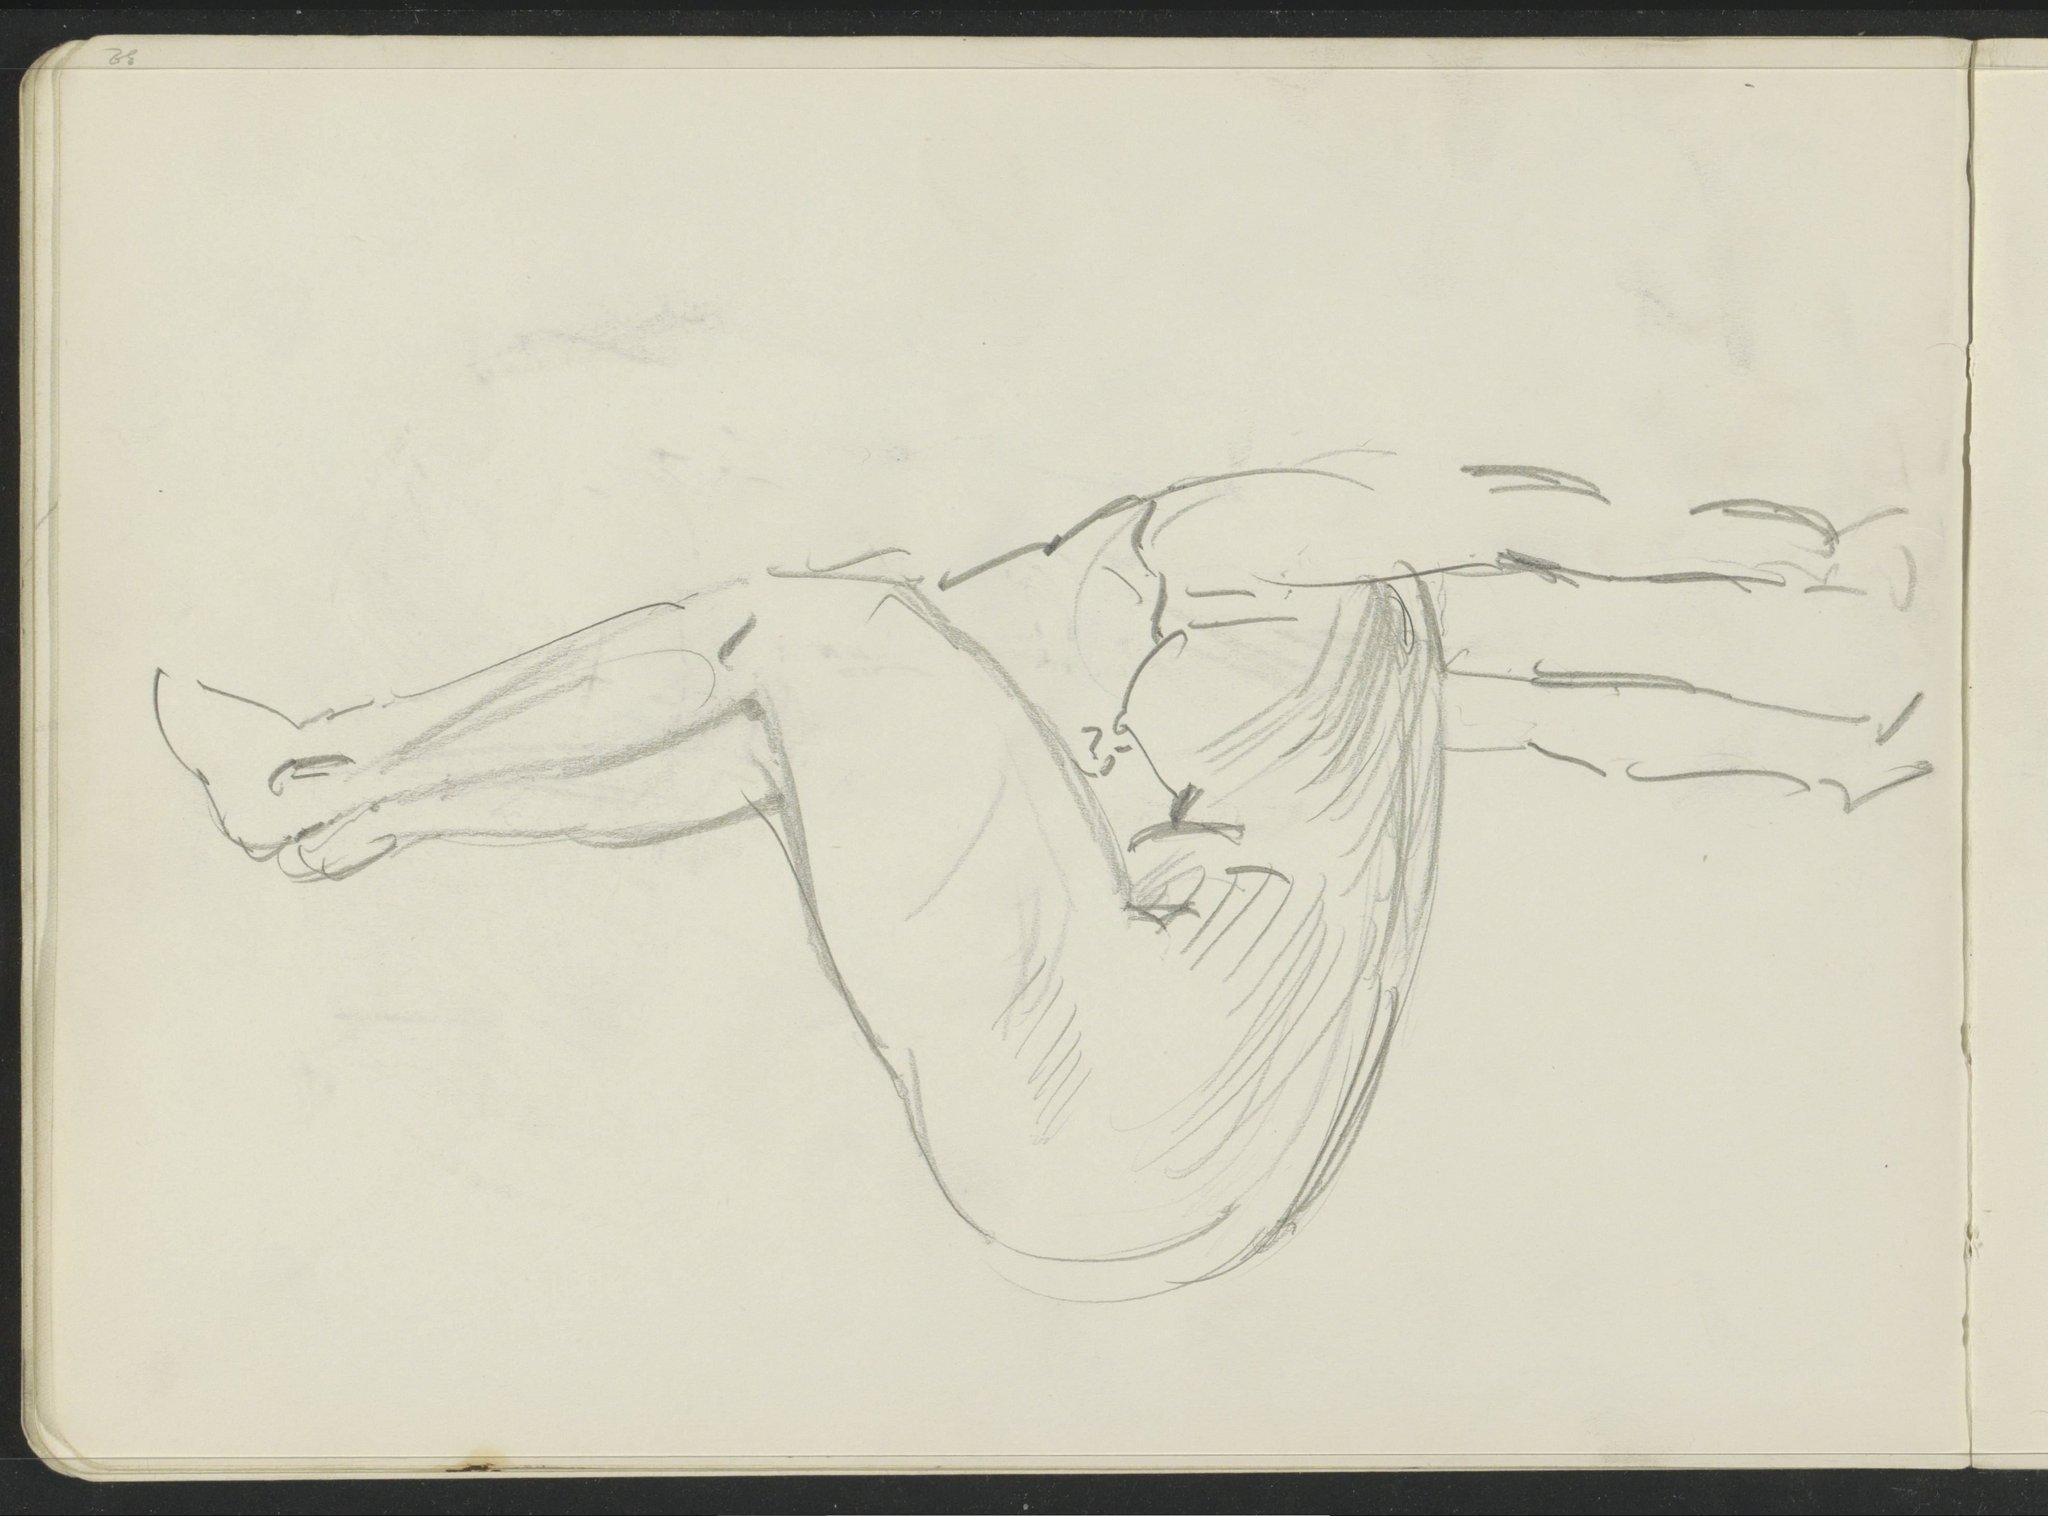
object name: sketchbook leaf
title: Gymnastiekend vrouwelijk naakt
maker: isaac israels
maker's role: draughtsman, painter, print maker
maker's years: 1865-1934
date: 1915-1934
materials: paper, pencil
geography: the hague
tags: gymnastic exercises on the ground, the (nude) human figure; 'corpo humano' (ripa) - aa - female human figure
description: Ze steunt op haar armen, schouders, hoofd en knieën. Blad 13 verso uit schetsboek XV met 22 bladen.